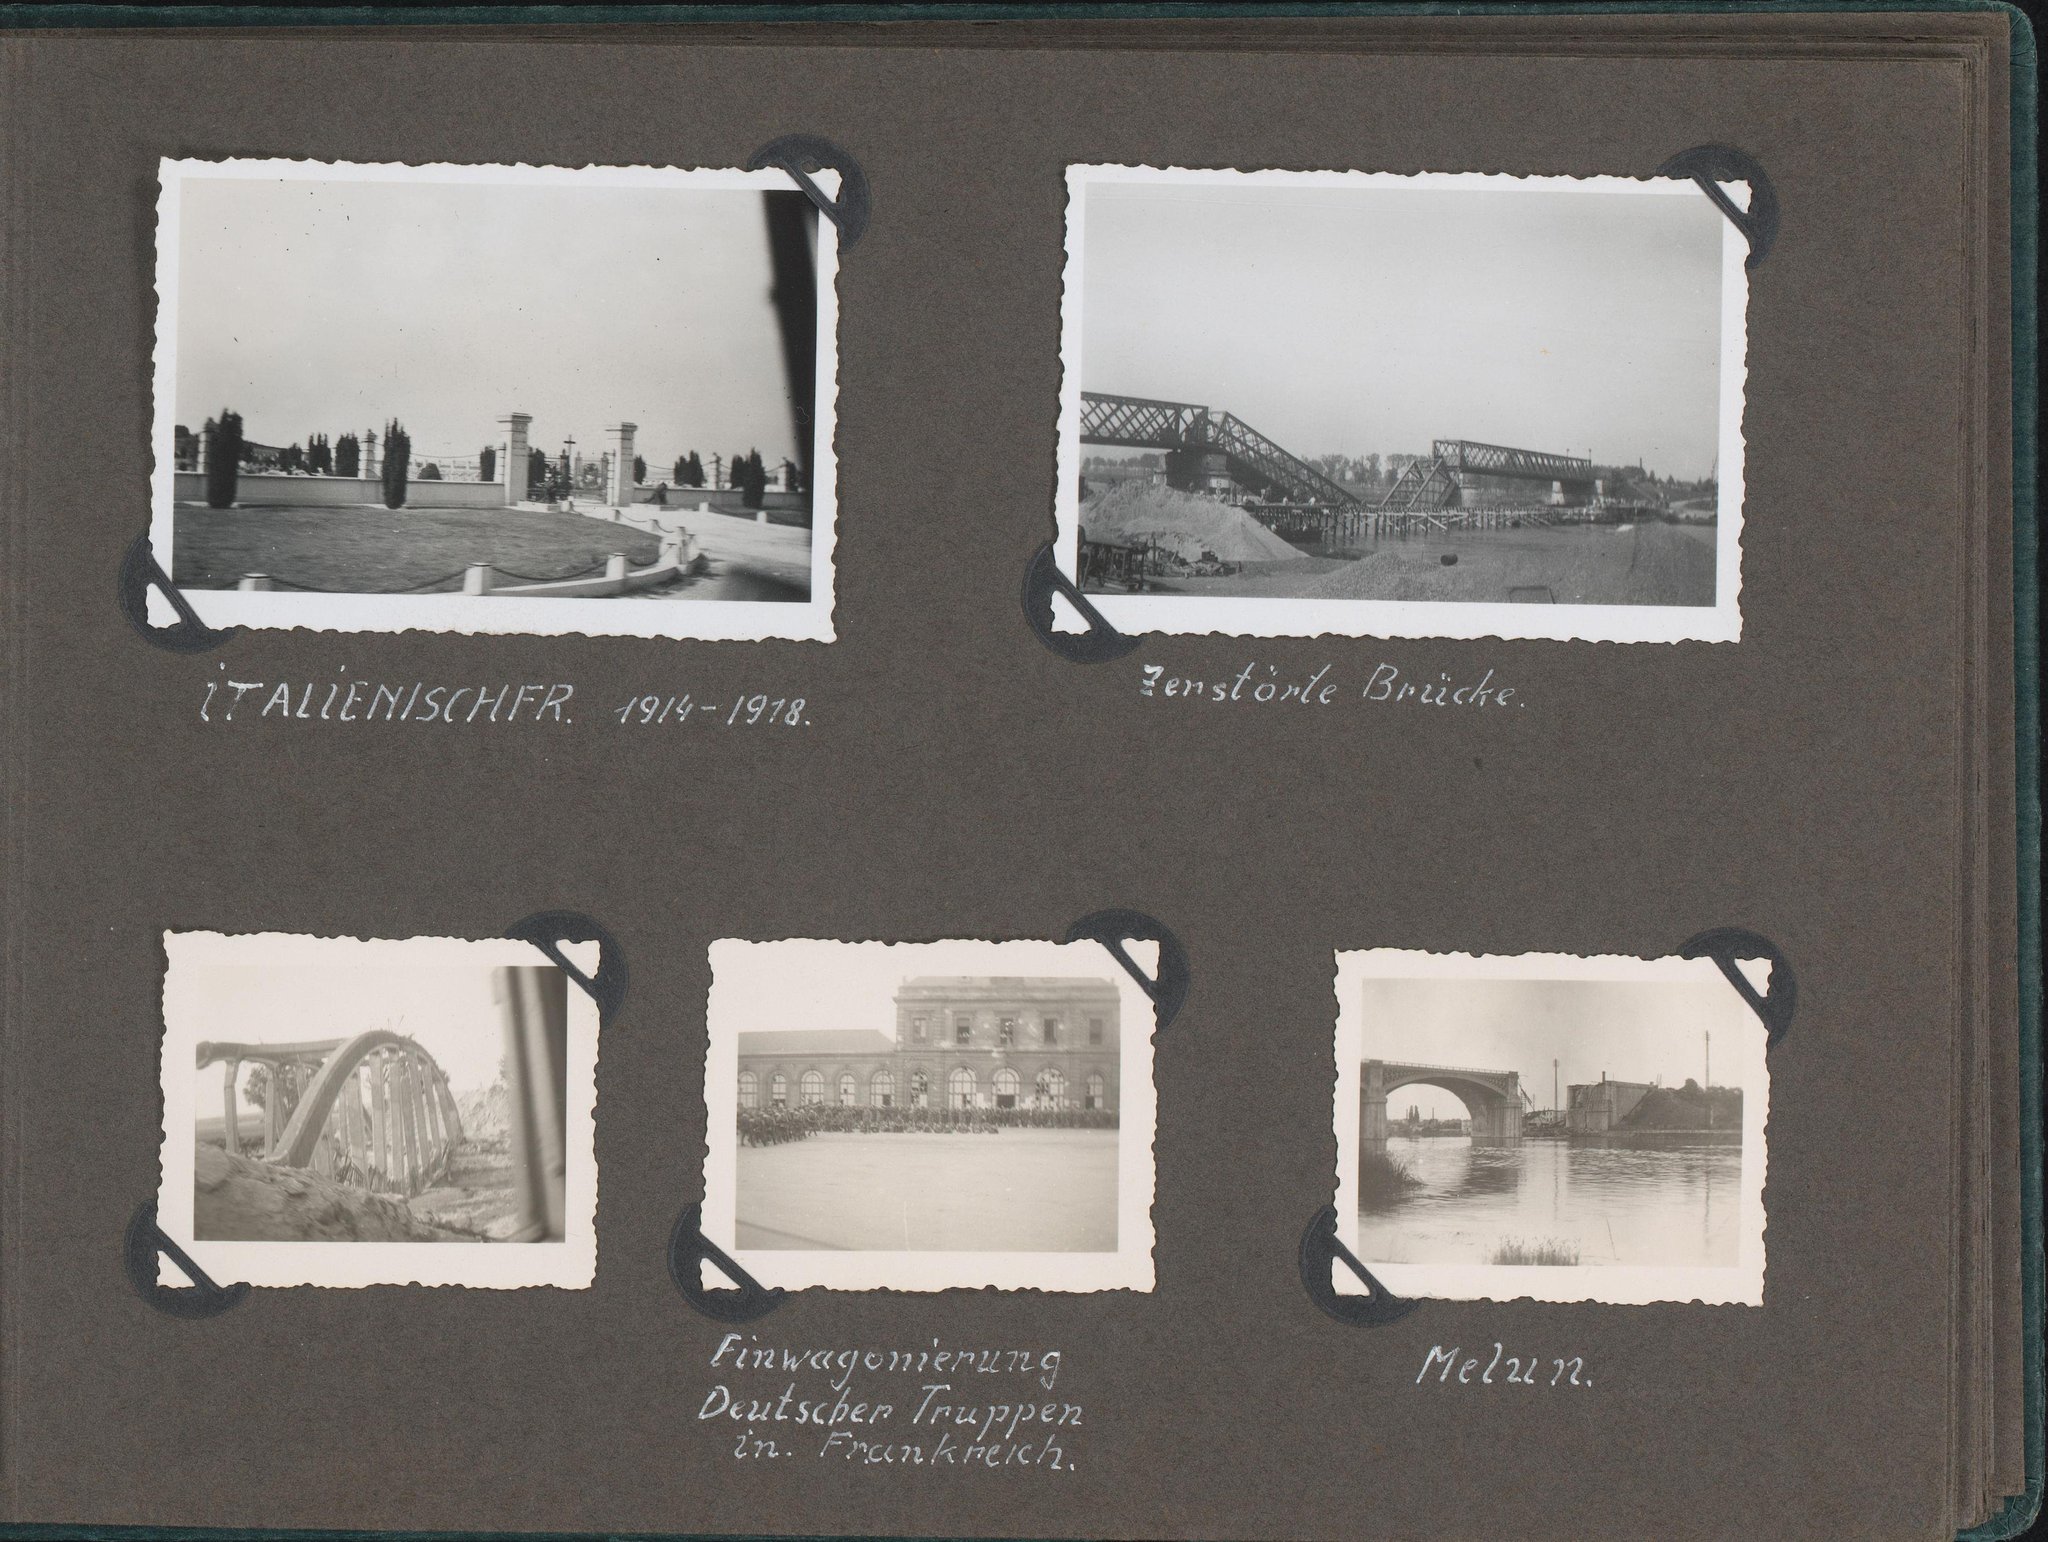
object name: photograph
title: Oorlogsschade in Frankrijk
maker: Anonymous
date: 1940-1945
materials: cardboard, photographic support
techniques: gelatin silver print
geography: france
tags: troop movements, transportation, devastated, ruined place or city (~ warfare), bridge, france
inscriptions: inscription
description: Albumblad met vijf foto's van oorlogsschade in steden en aan bruggen in Frankrijk. Onderdeel van het fotoalbum 'Kriegserinnerungen' 1940-1945.